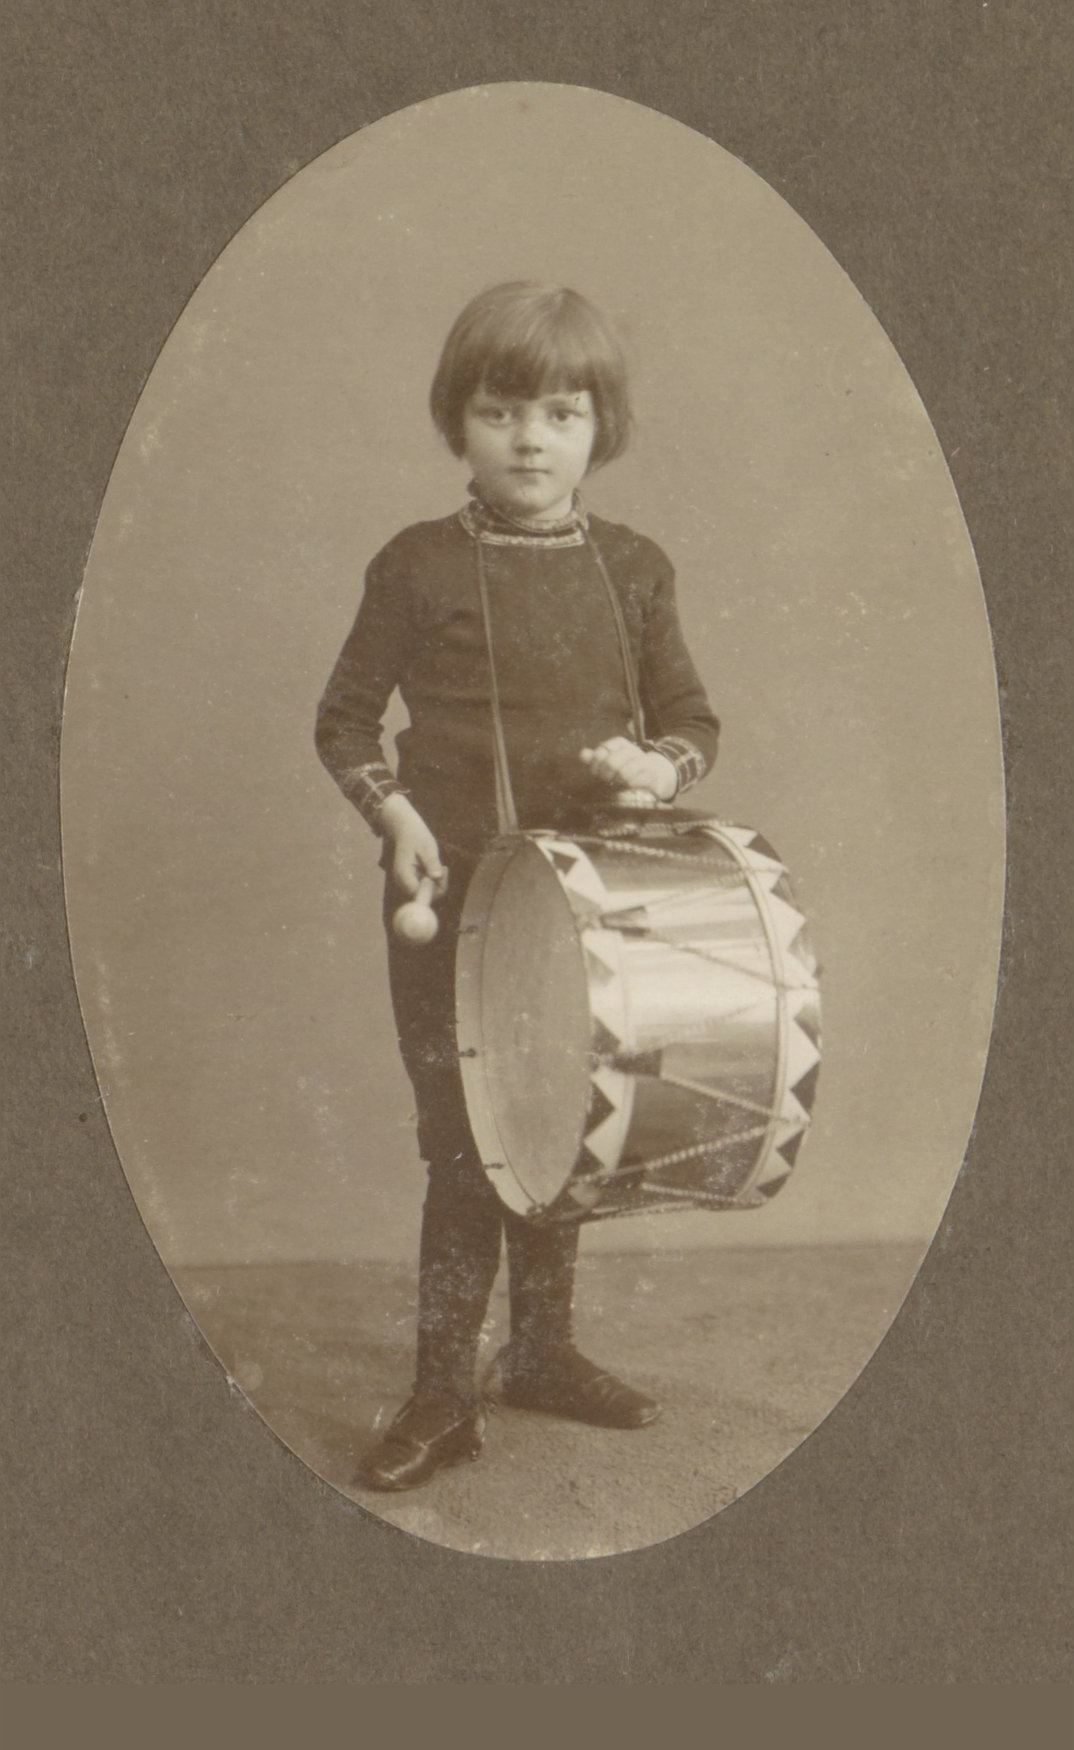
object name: photograph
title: Portret van een kind met een trommel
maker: cornelis johannes lodewicus vermeulen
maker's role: fotograaf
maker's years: 1861-1936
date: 1900-1920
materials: paper, photographic support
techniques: gelatin silver print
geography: the hague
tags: studio requisites ~ photographer, child, drum (musical instrument), the hague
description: Onderdeel van Fotoalbum met opnames van het gezin en het huis van fotograaf C.J.L. Vermeulen in Den Haag.